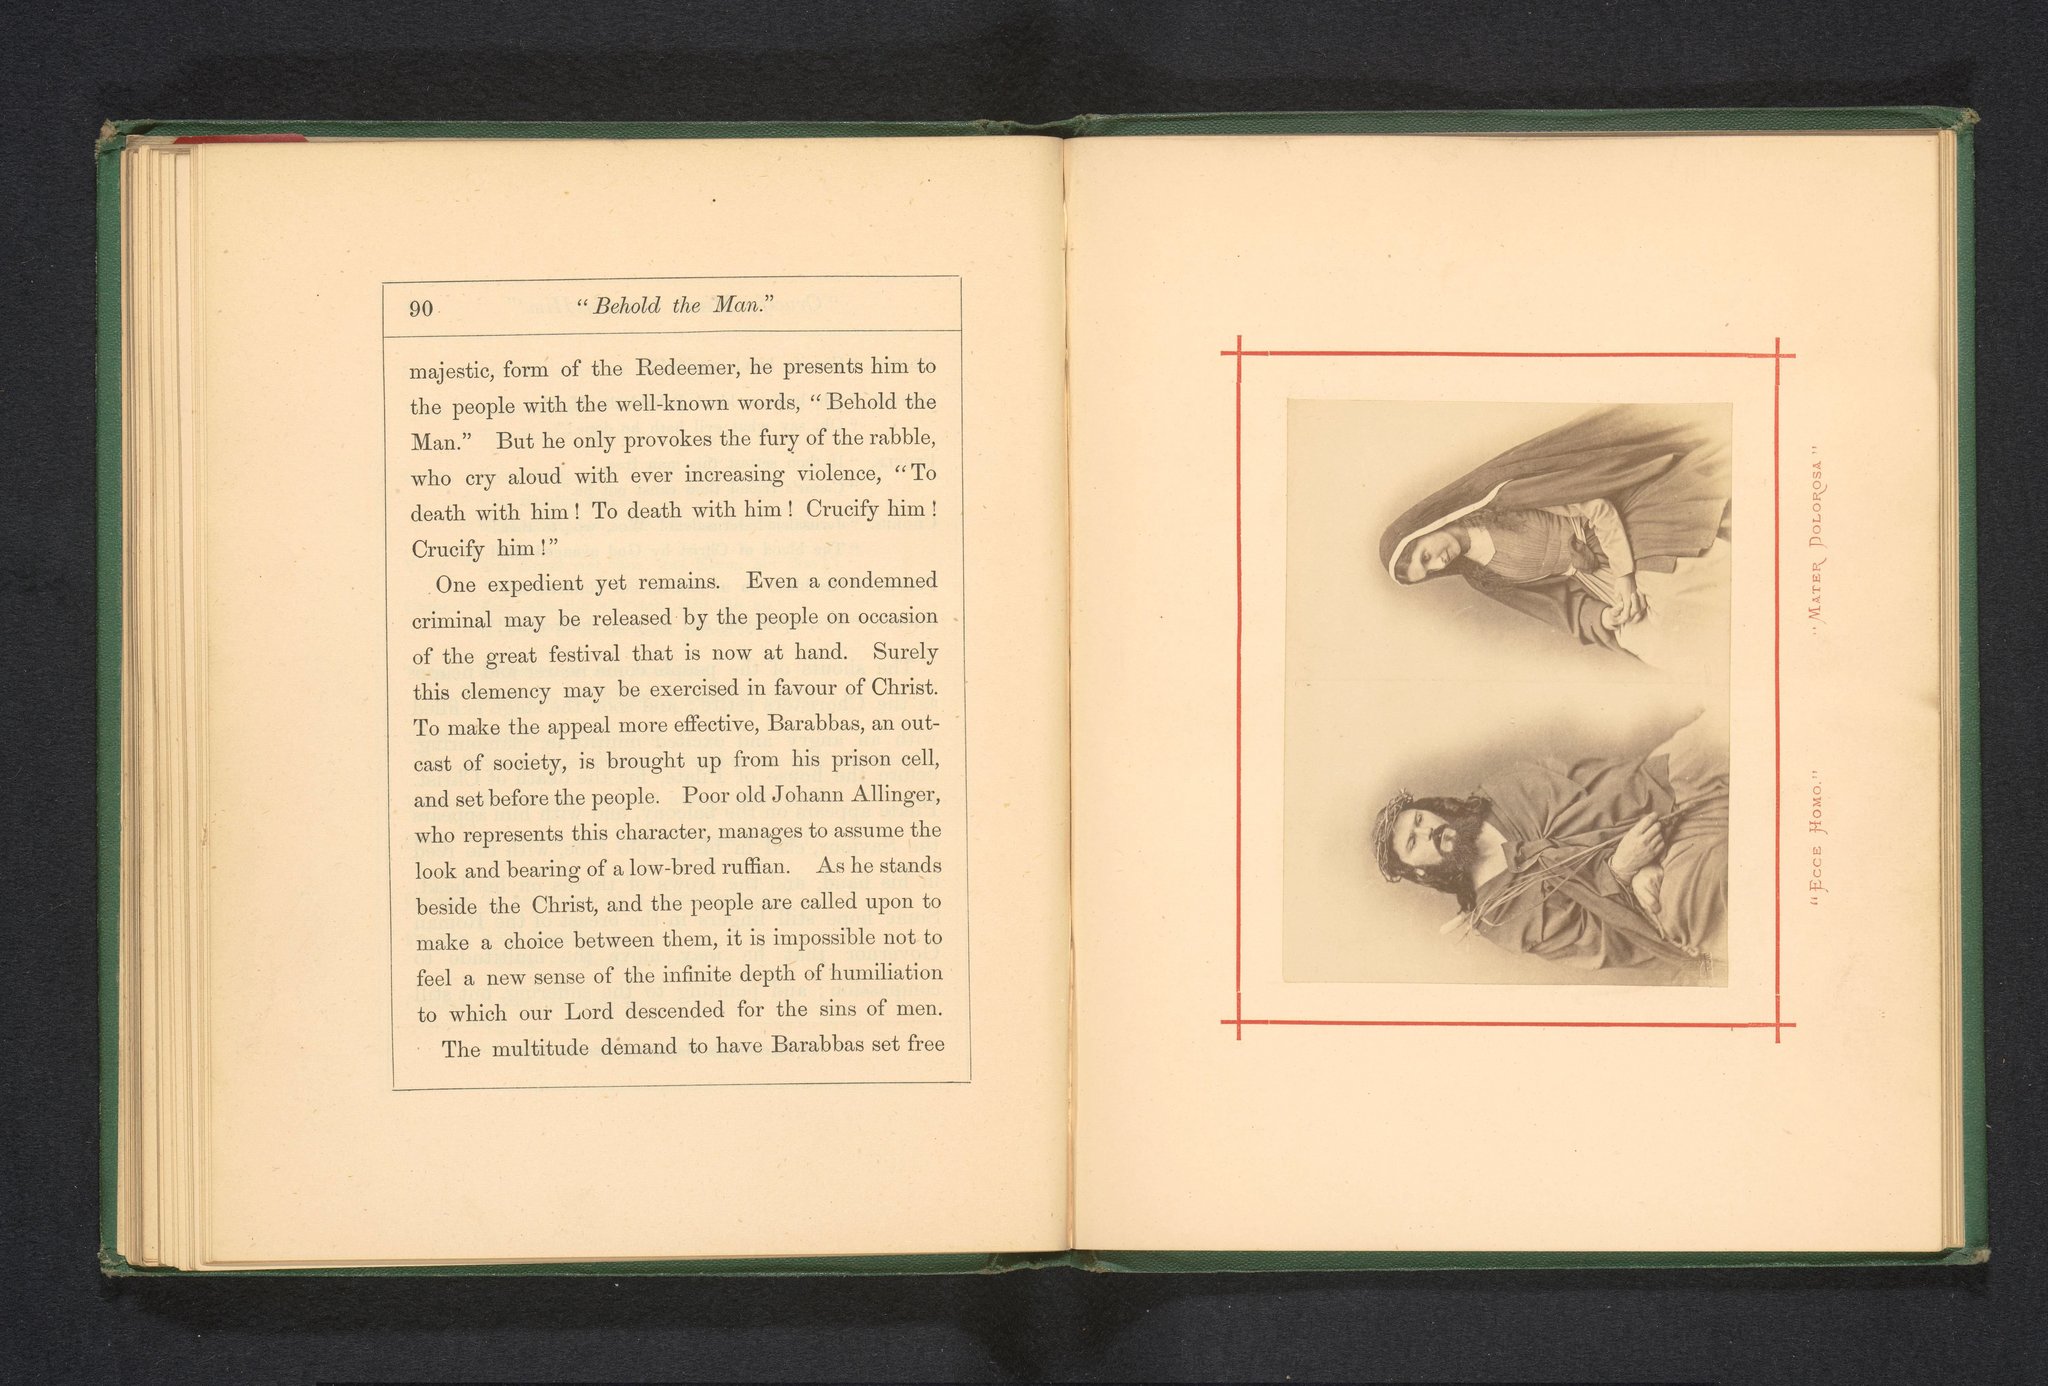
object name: photograph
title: "Ecce Homo". "Mater Dolorosa"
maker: joseph albert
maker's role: printer, publisher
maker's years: 1825-1886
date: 1867-1872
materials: photographic support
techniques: albumen print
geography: oberammergau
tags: 'mater dolorosa', christ alone (also called 'ecce homo'), actor (on the stage), oberammergau